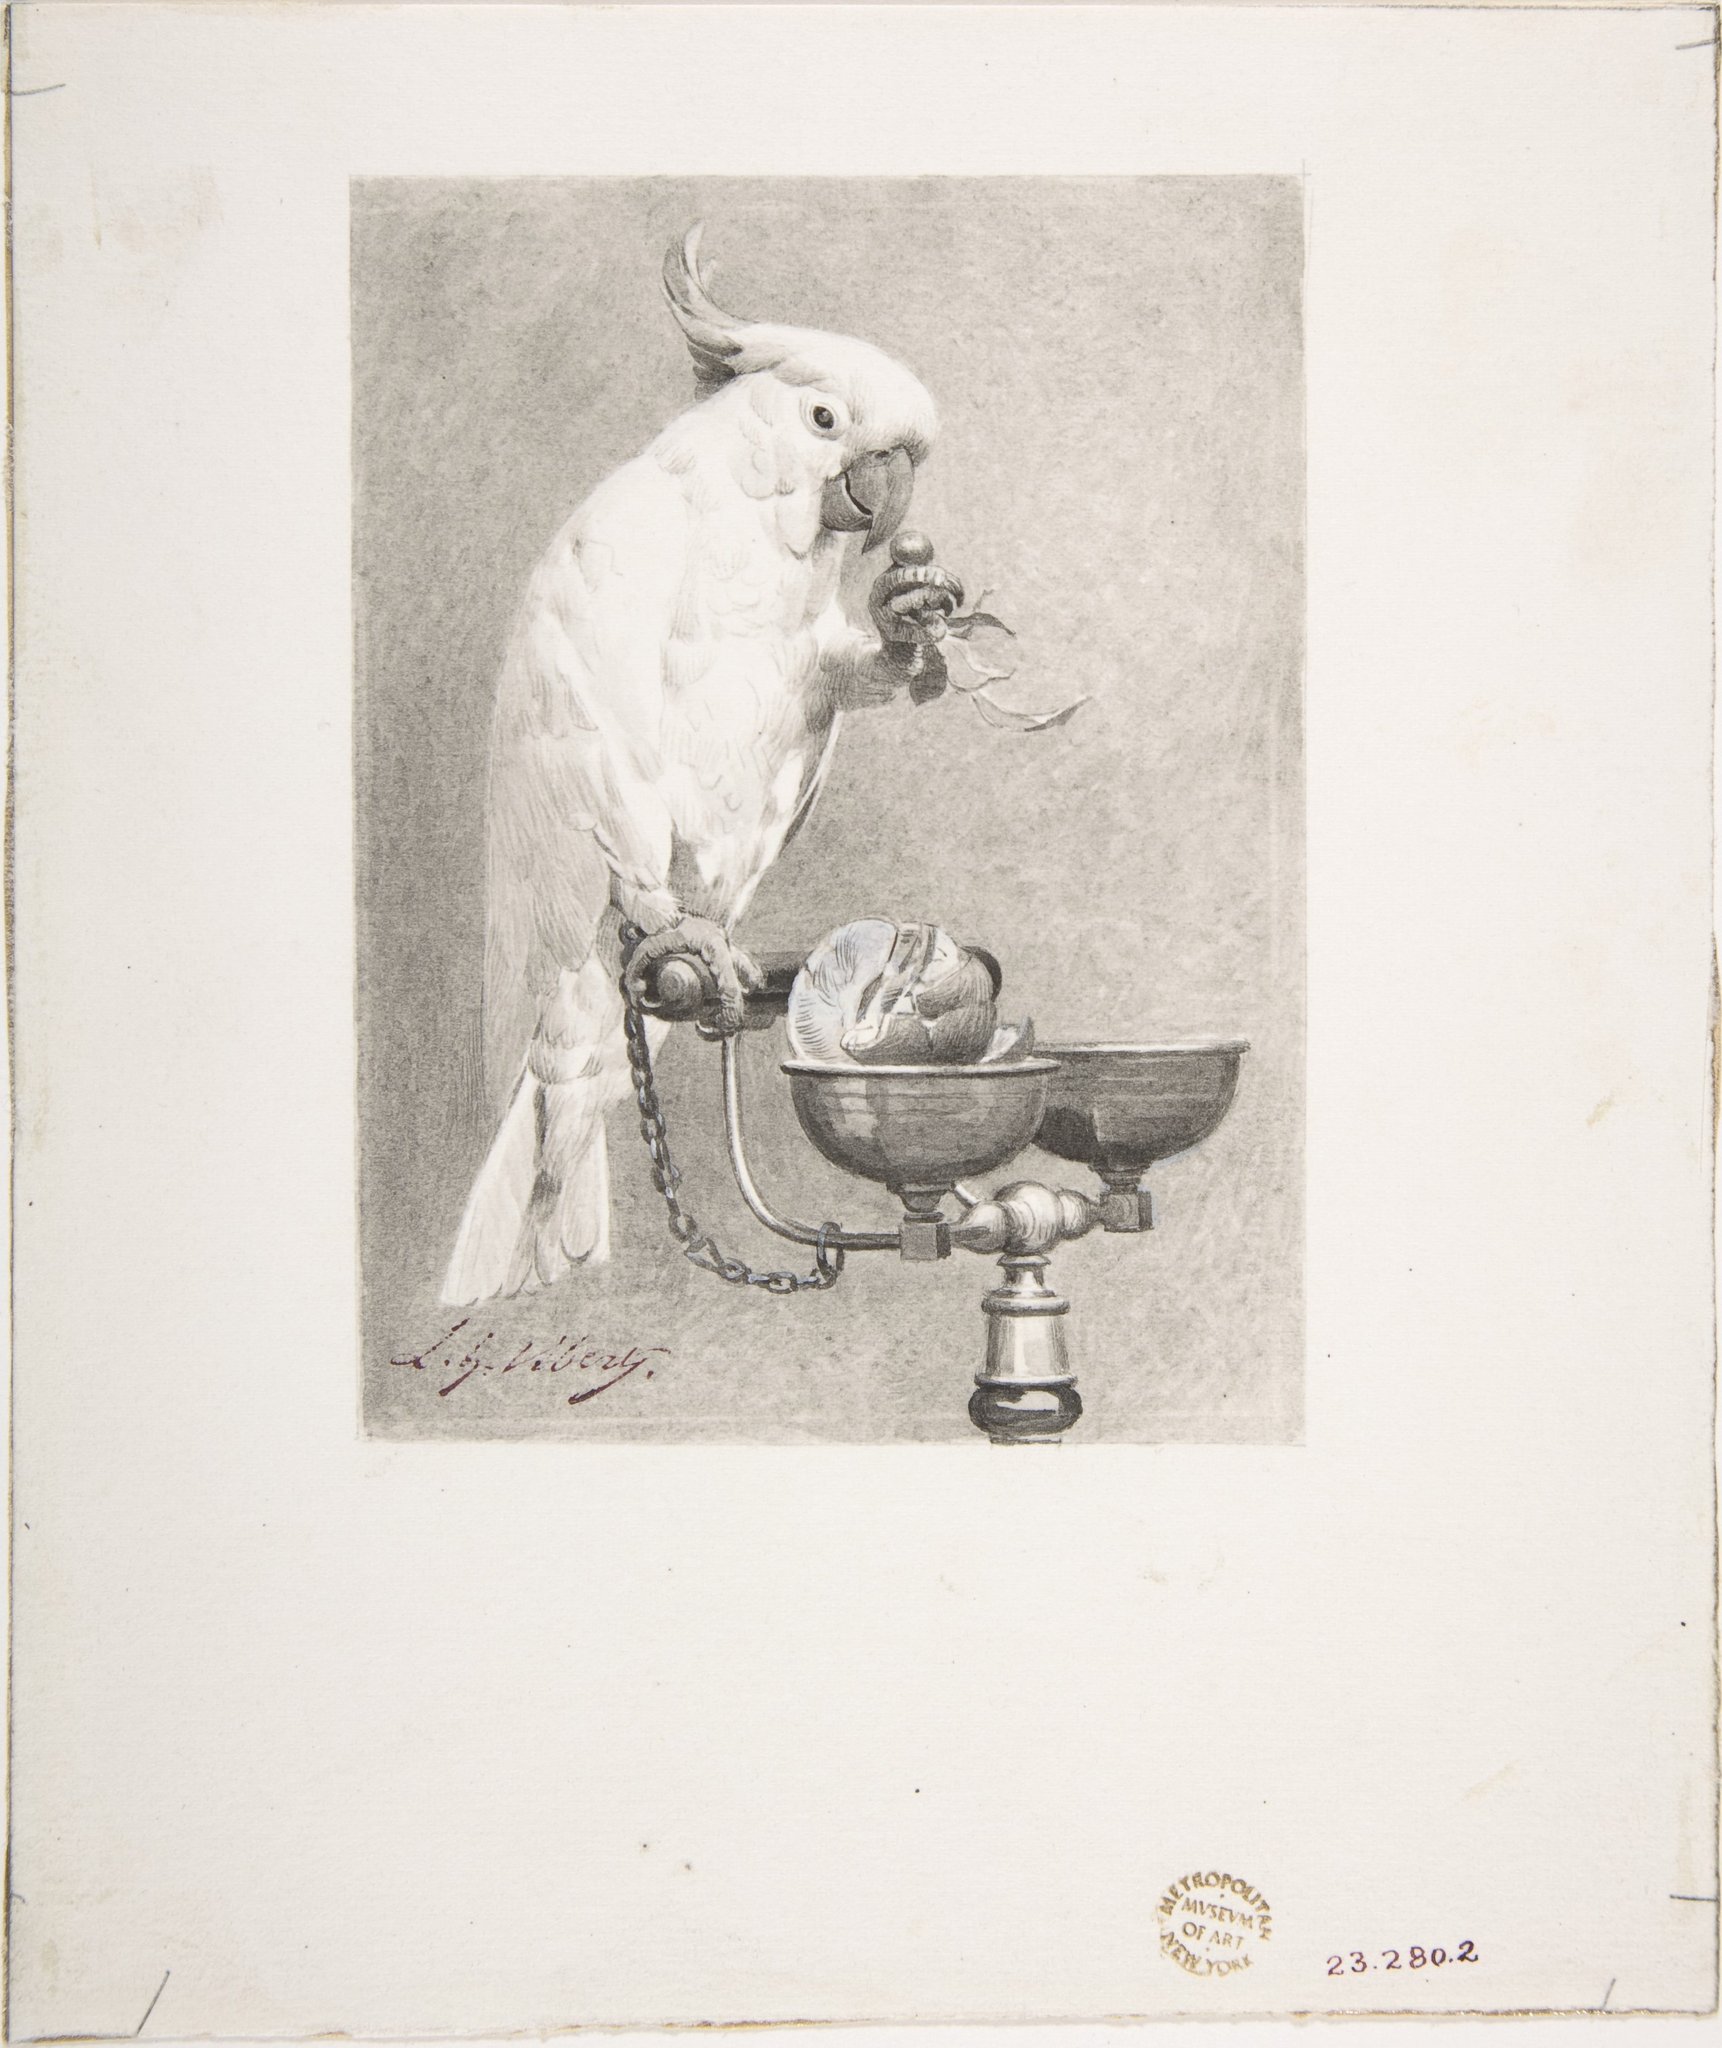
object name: drawing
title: The Sedate Parrot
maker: jean-georges vibert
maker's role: artist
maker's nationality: french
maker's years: 1840-1902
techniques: wash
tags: fruit,parrots